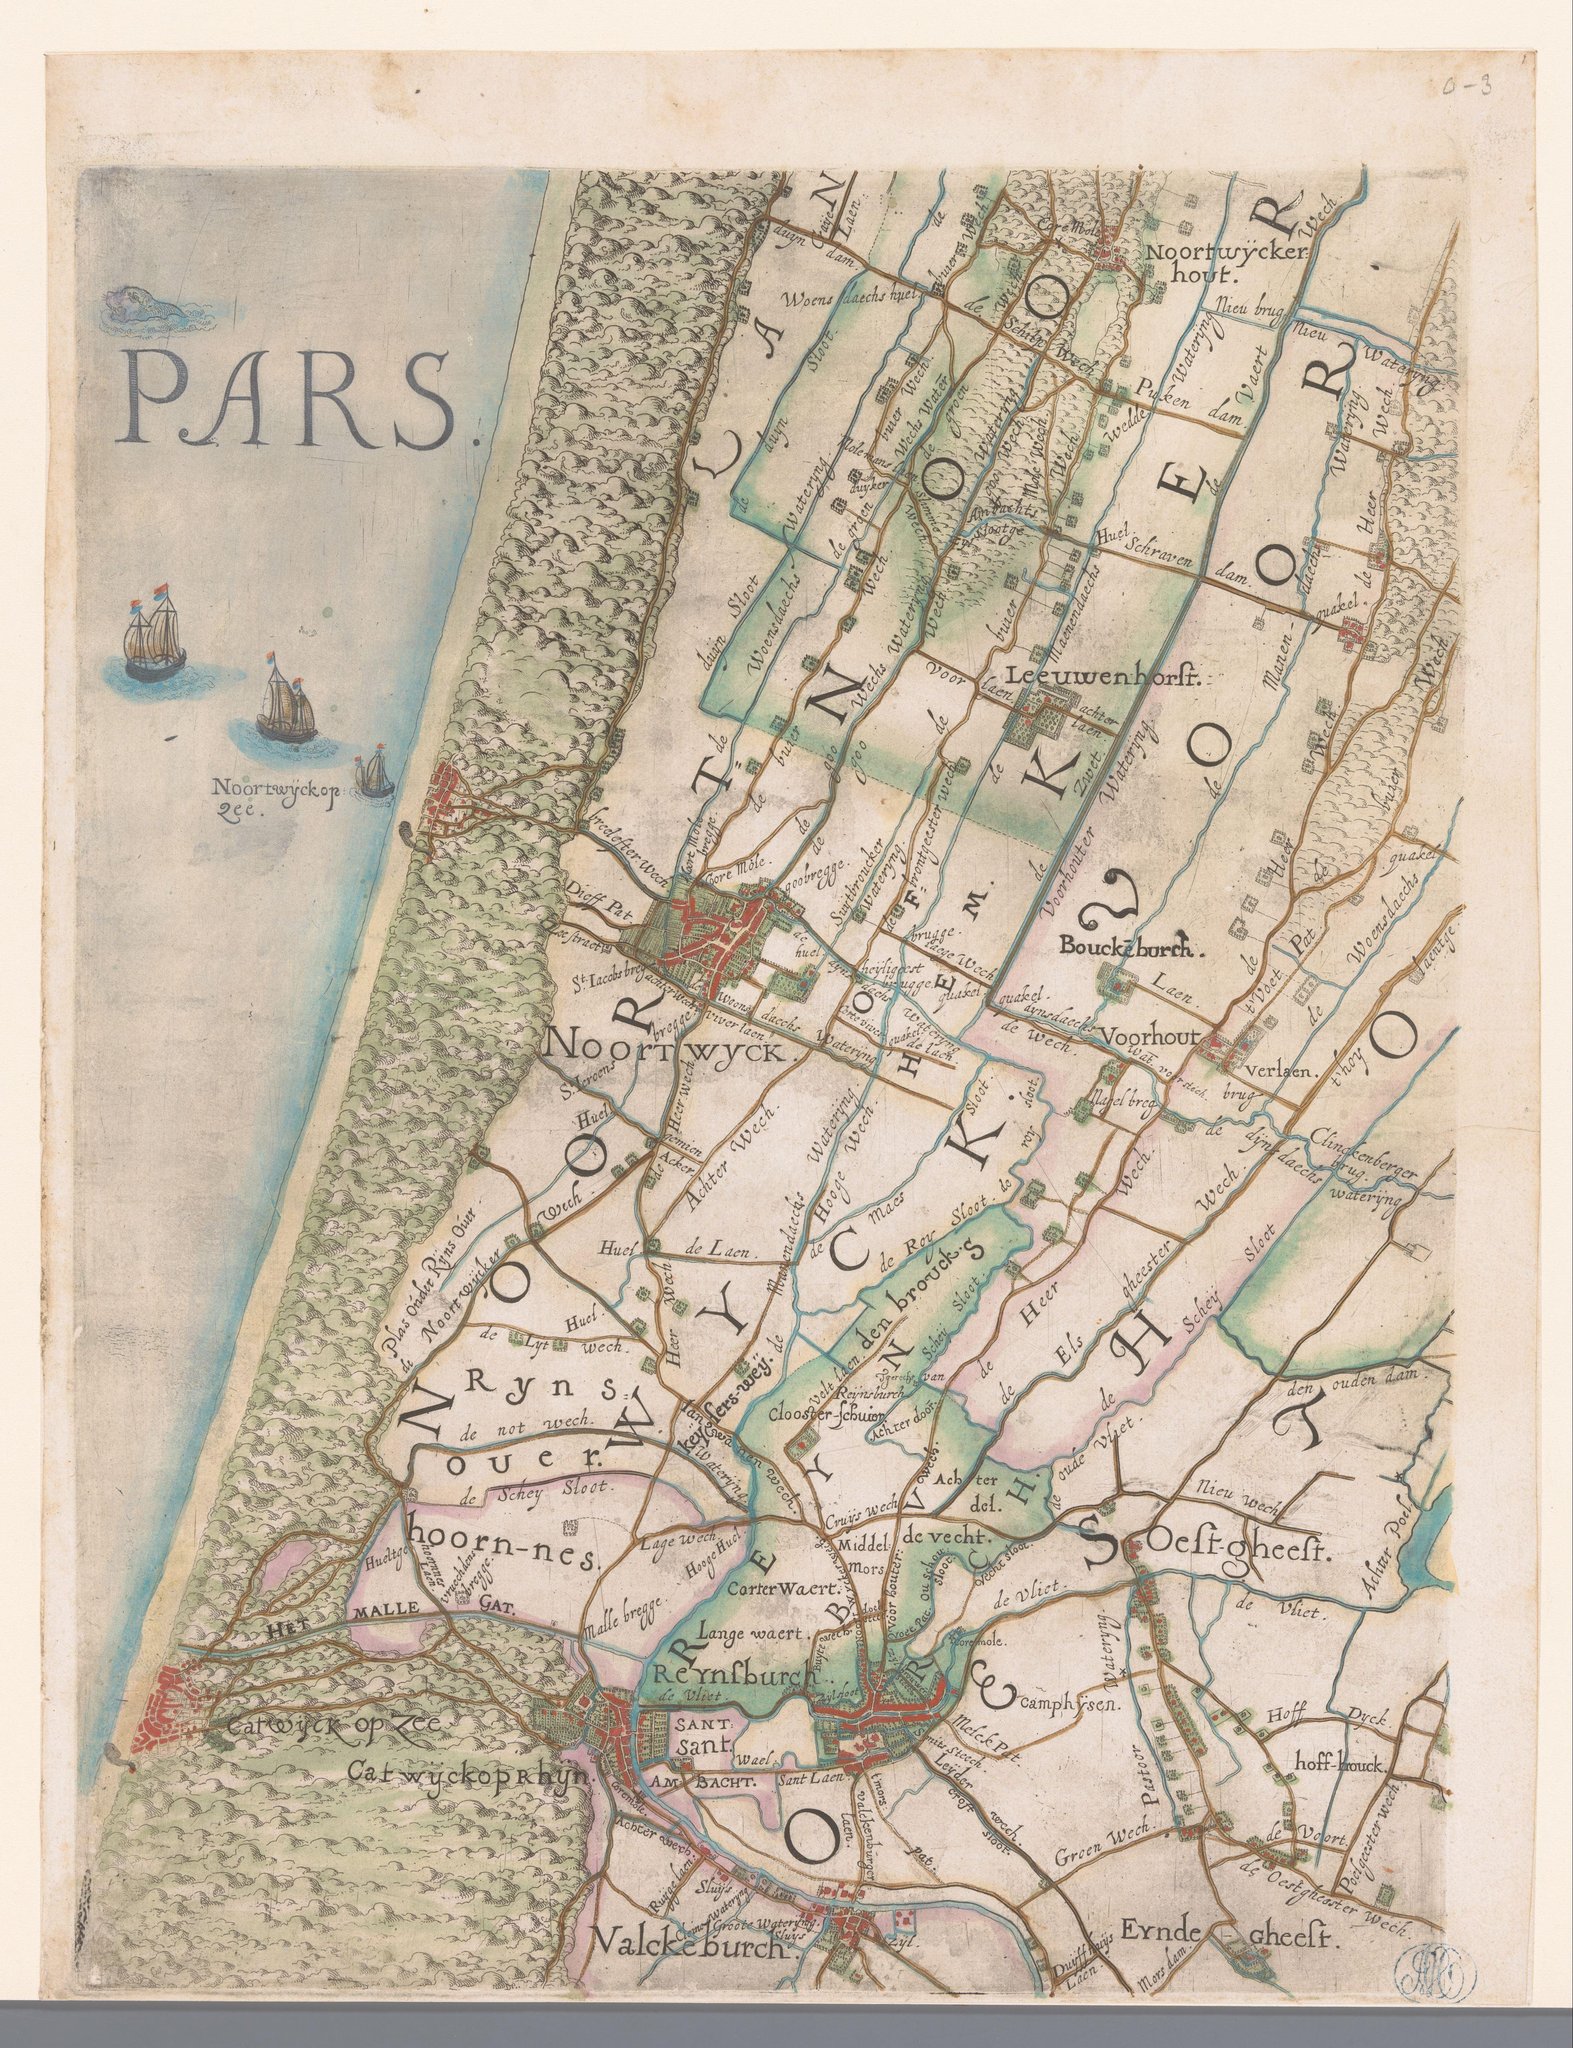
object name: map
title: Deel van een kaart van het Hoogheemraadschap van Rijnland, met Noordwijk en omgeving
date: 1615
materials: paper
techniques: engraving, etching, hand coloring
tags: maps of separate countries or regions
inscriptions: collector's mark: Lugt 195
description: Deel van een kaart van Rijnland, bestaande uit 27 delen.